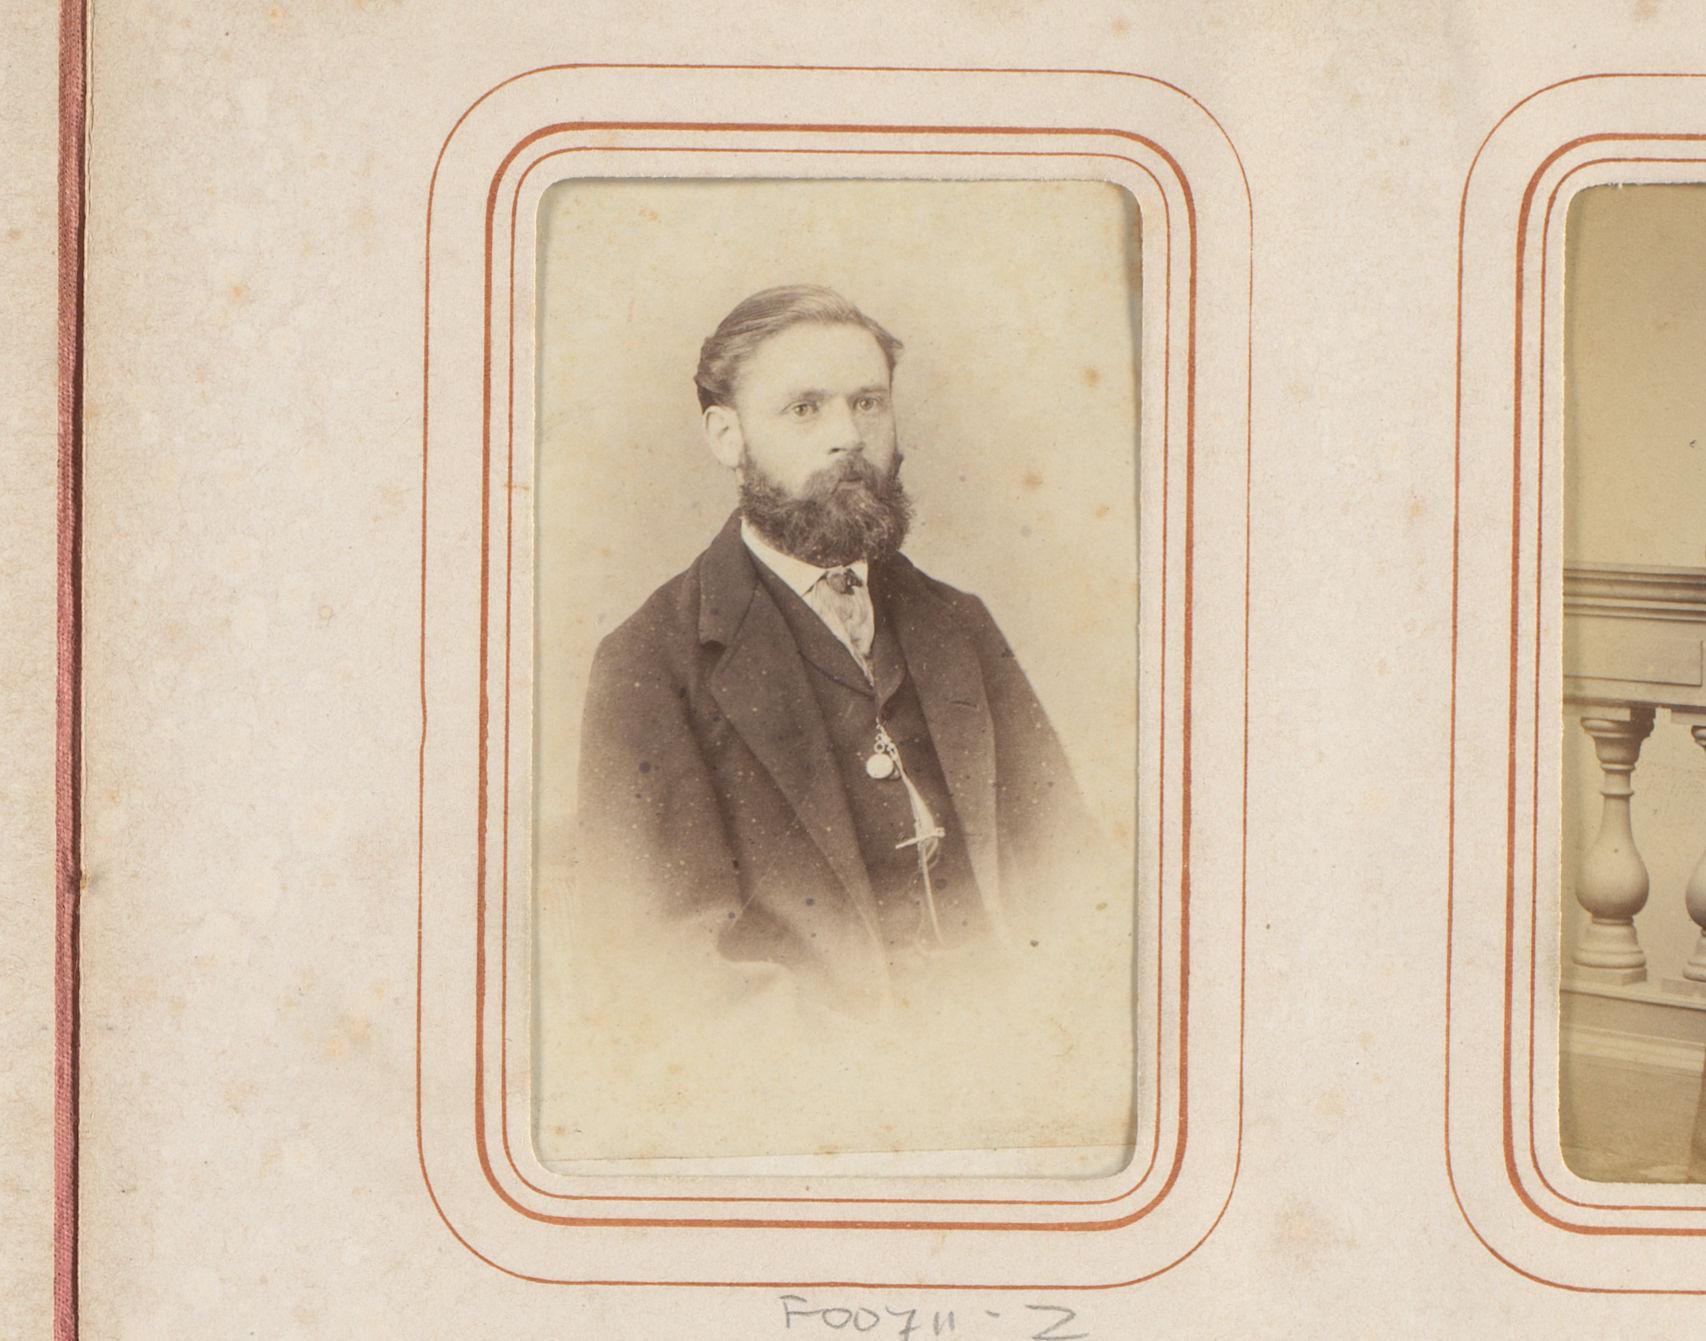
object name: carte de visite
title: Portret van een man met baard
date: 1859-1869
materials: cardboard, photographic support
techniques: albumen print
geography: amsterdam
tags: historical persons, beard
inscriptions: inscription: ‘Tresling & Co./ Photographie en Lithographie/ Amsterdam/ Singel bij de Torensluis G.364 en 403’